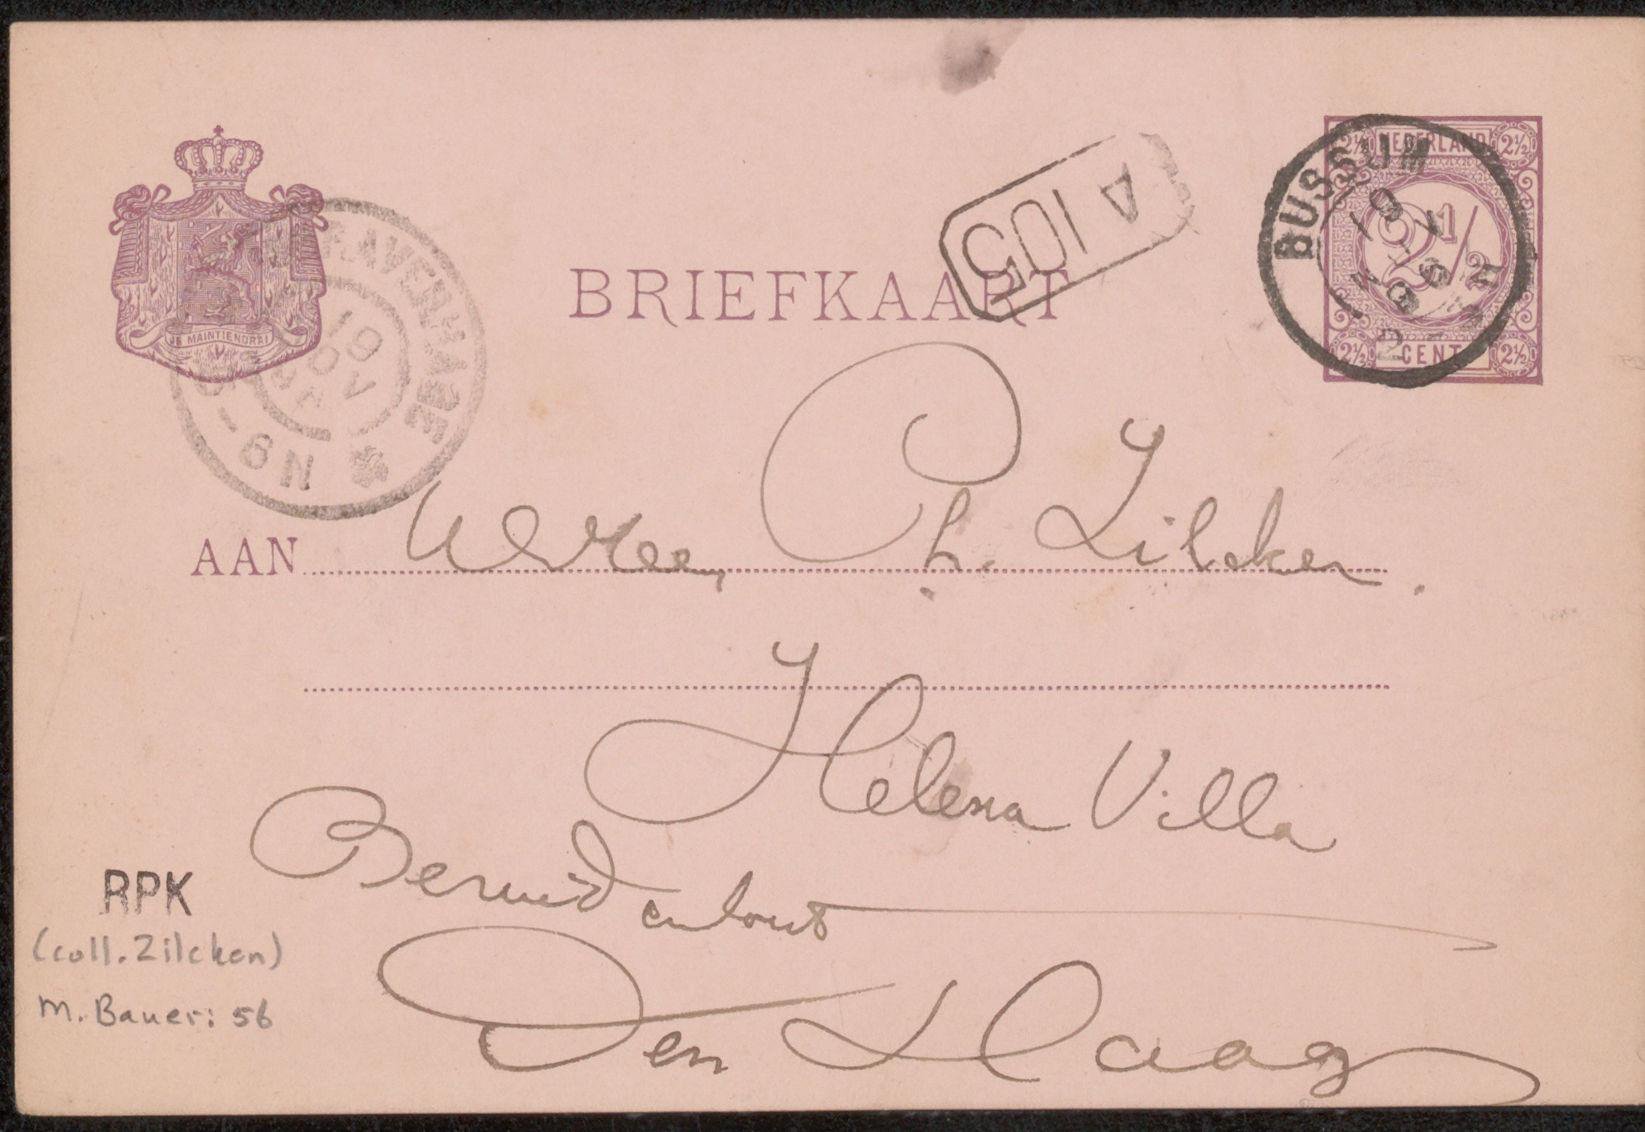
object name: postcard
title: Briefkaart aan Philip Zilcken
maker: marius bauer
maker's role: draughtsman, print maker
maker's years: 1867-1932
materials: cardboard, ink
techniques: pen, writing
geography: bussum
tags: painter, philip zilcken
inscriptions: collector's mark: ‘RPK’